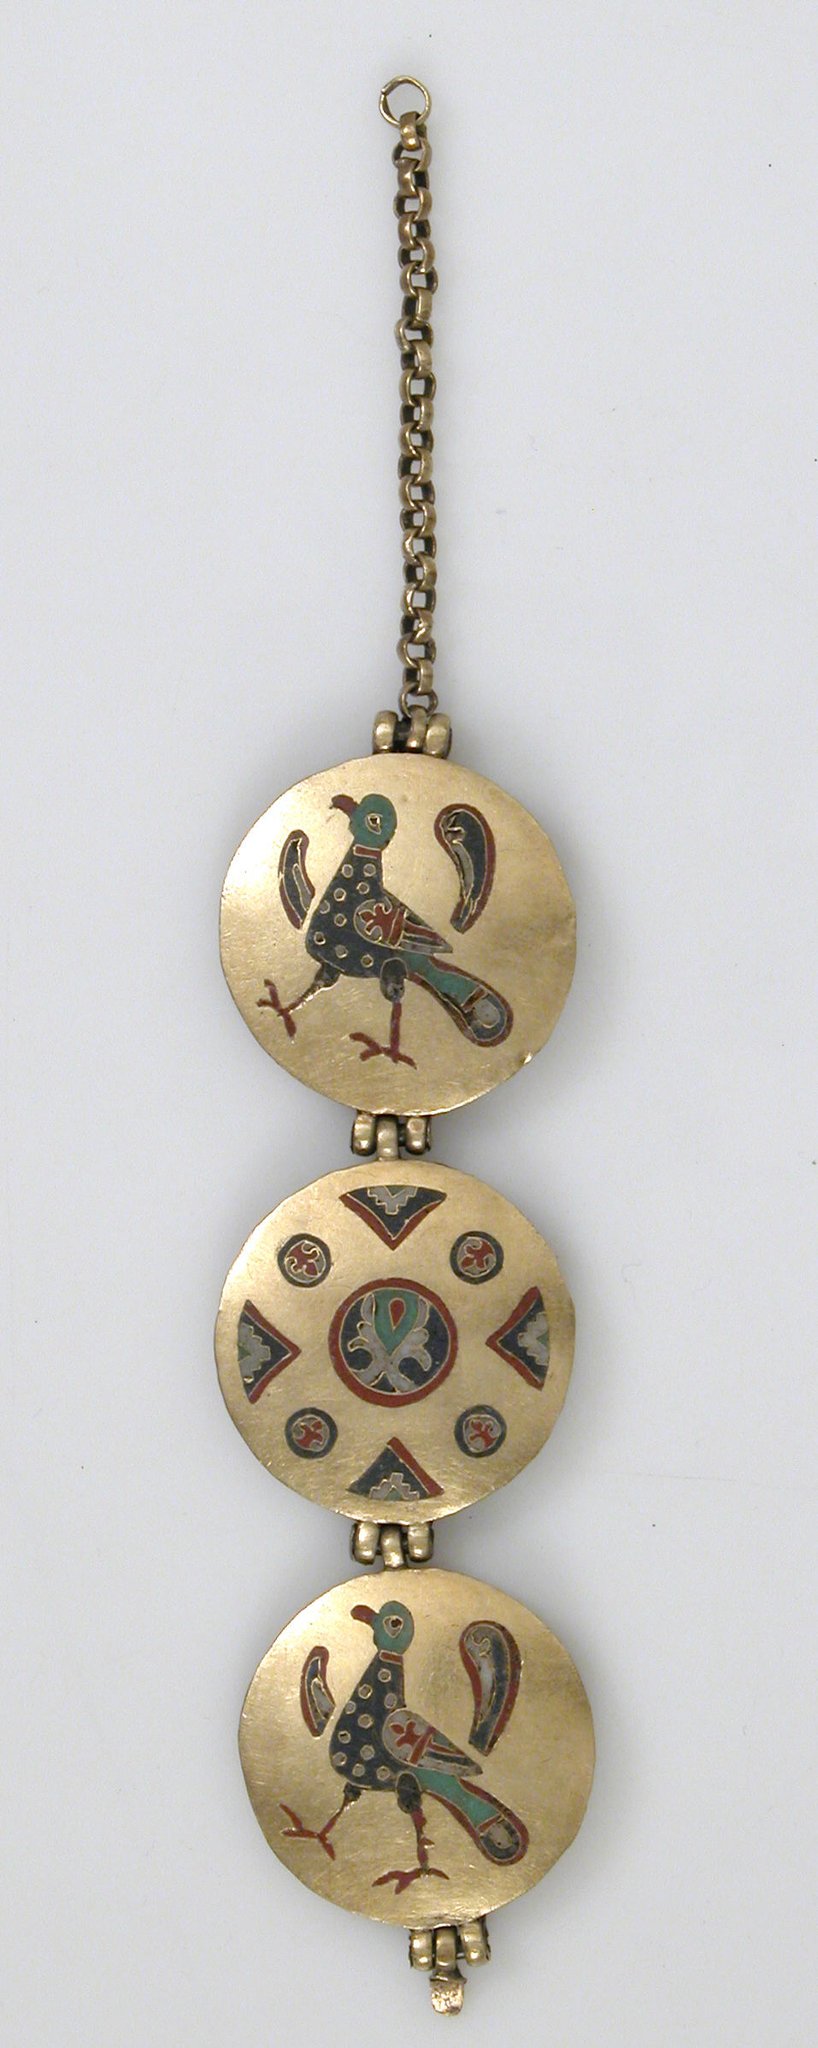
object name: dress ornament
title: Chain with Birds and Geometric Motifs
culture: kyivan rus’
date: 1000-1200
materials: enamel, gold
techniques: enamel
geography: ukraine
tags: birds